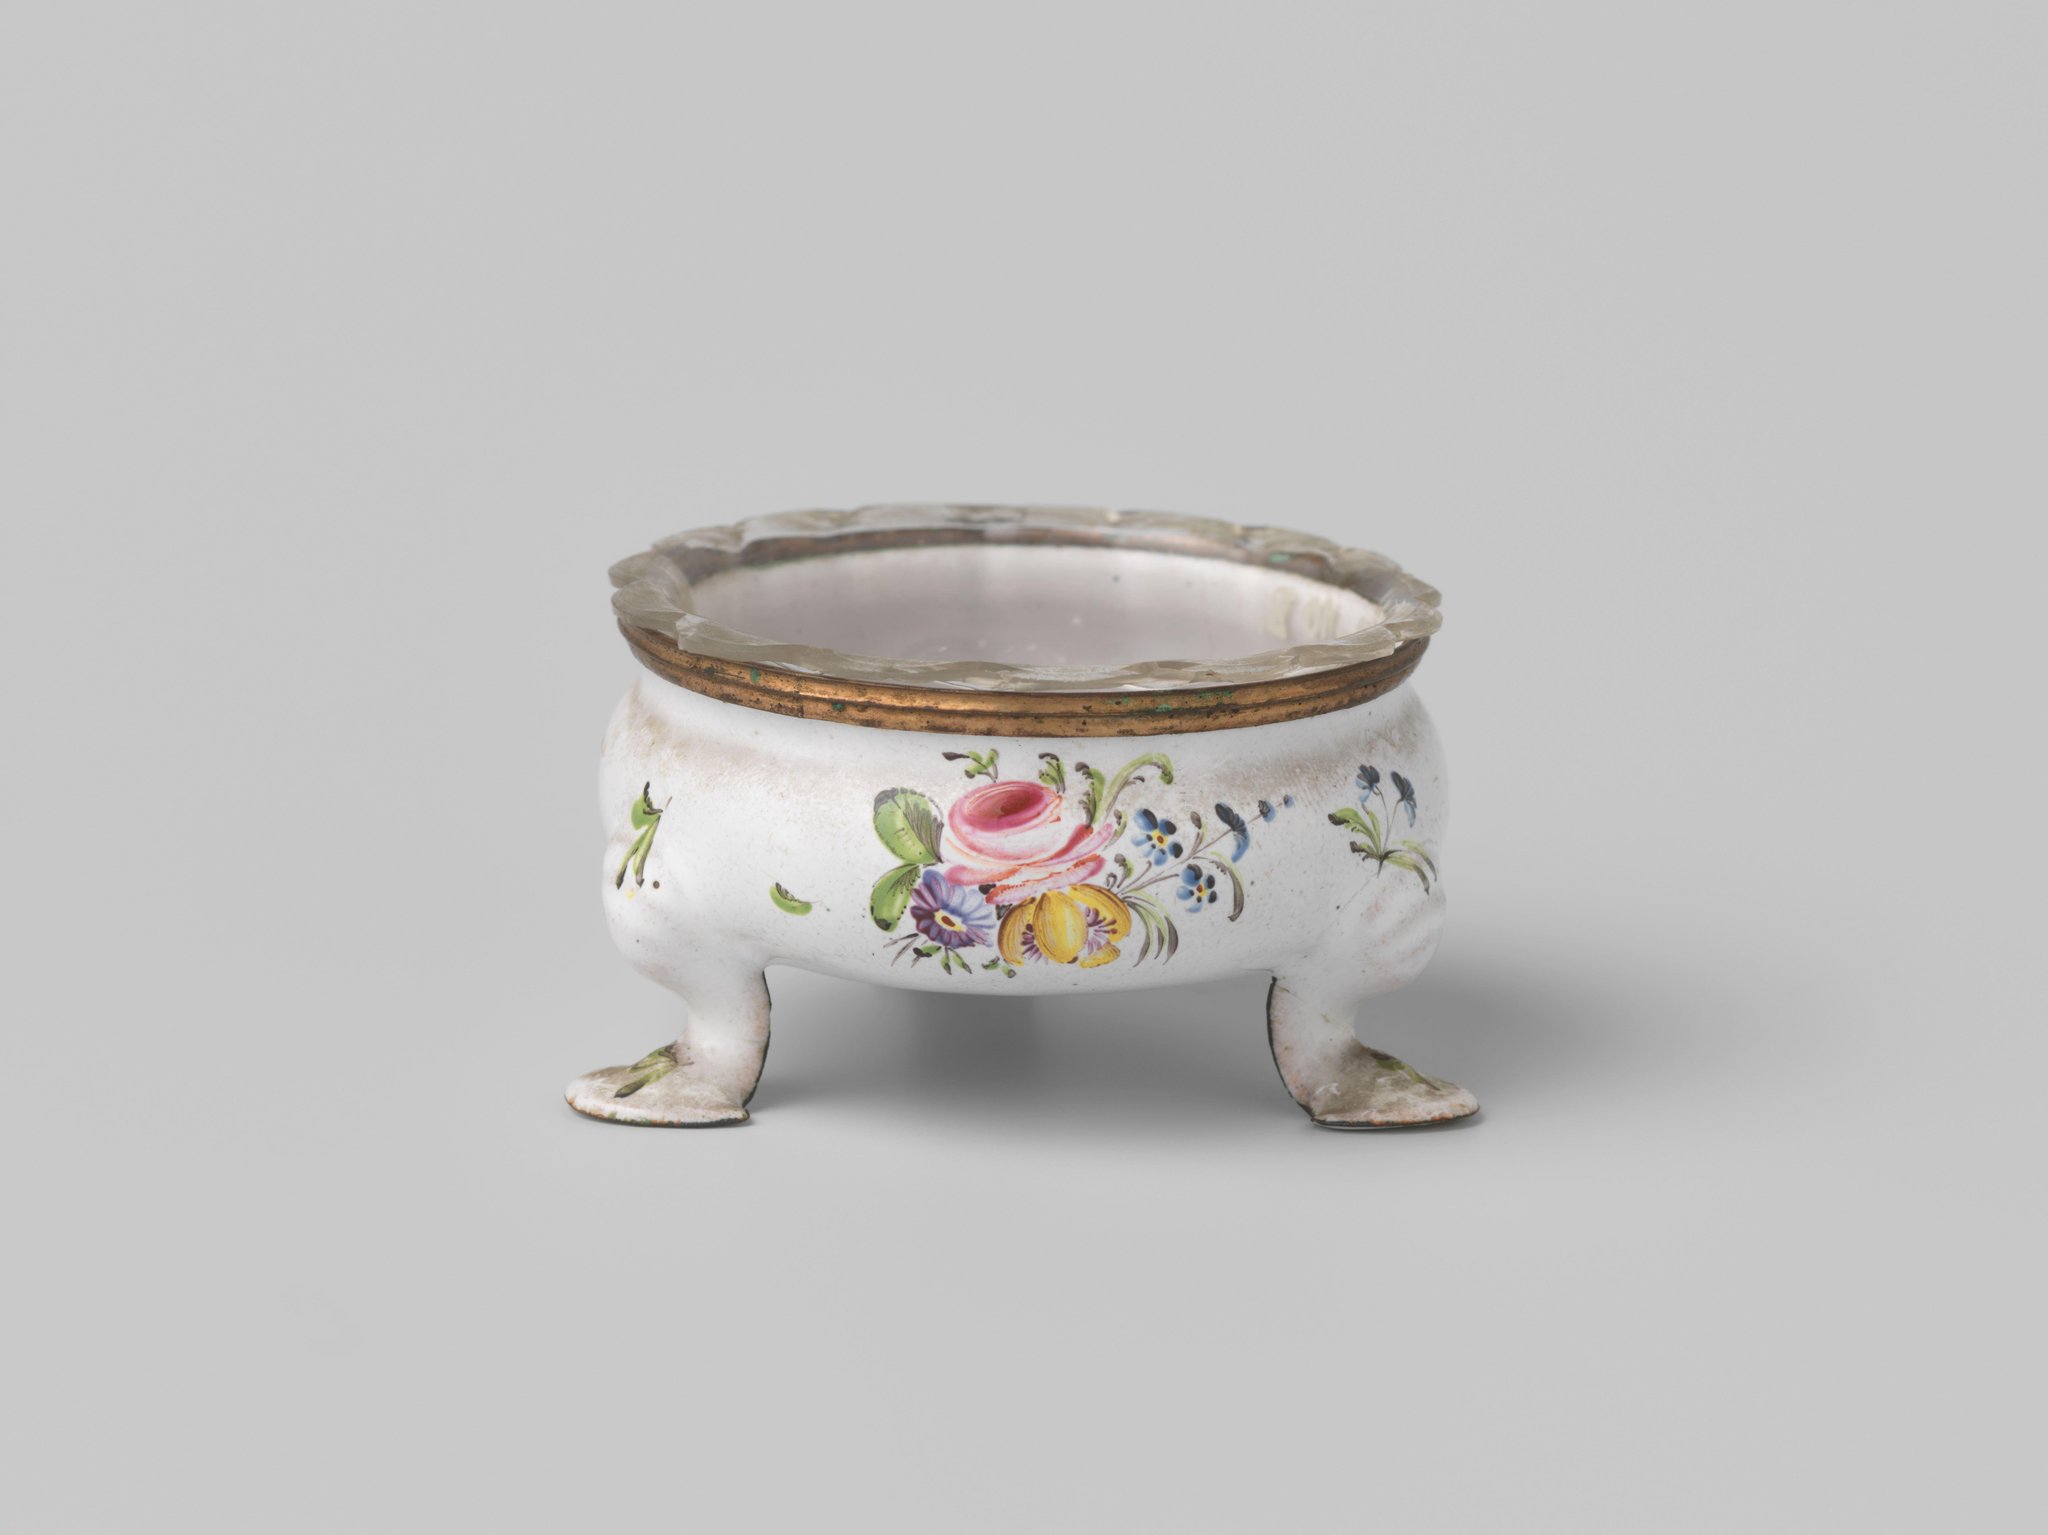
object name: salt condiment vessel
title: Zoutvat van koper, geëmailleerd en met glazen bak met een tekening van naturalistische bloemen op een witte grond.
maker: Anonymous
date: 1700-1800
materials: copper, glass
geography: england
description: Zoutvat van koper, geëmailleerd, en met een glazen bak met een tekening van naturalistische bloemen op een witte grond.